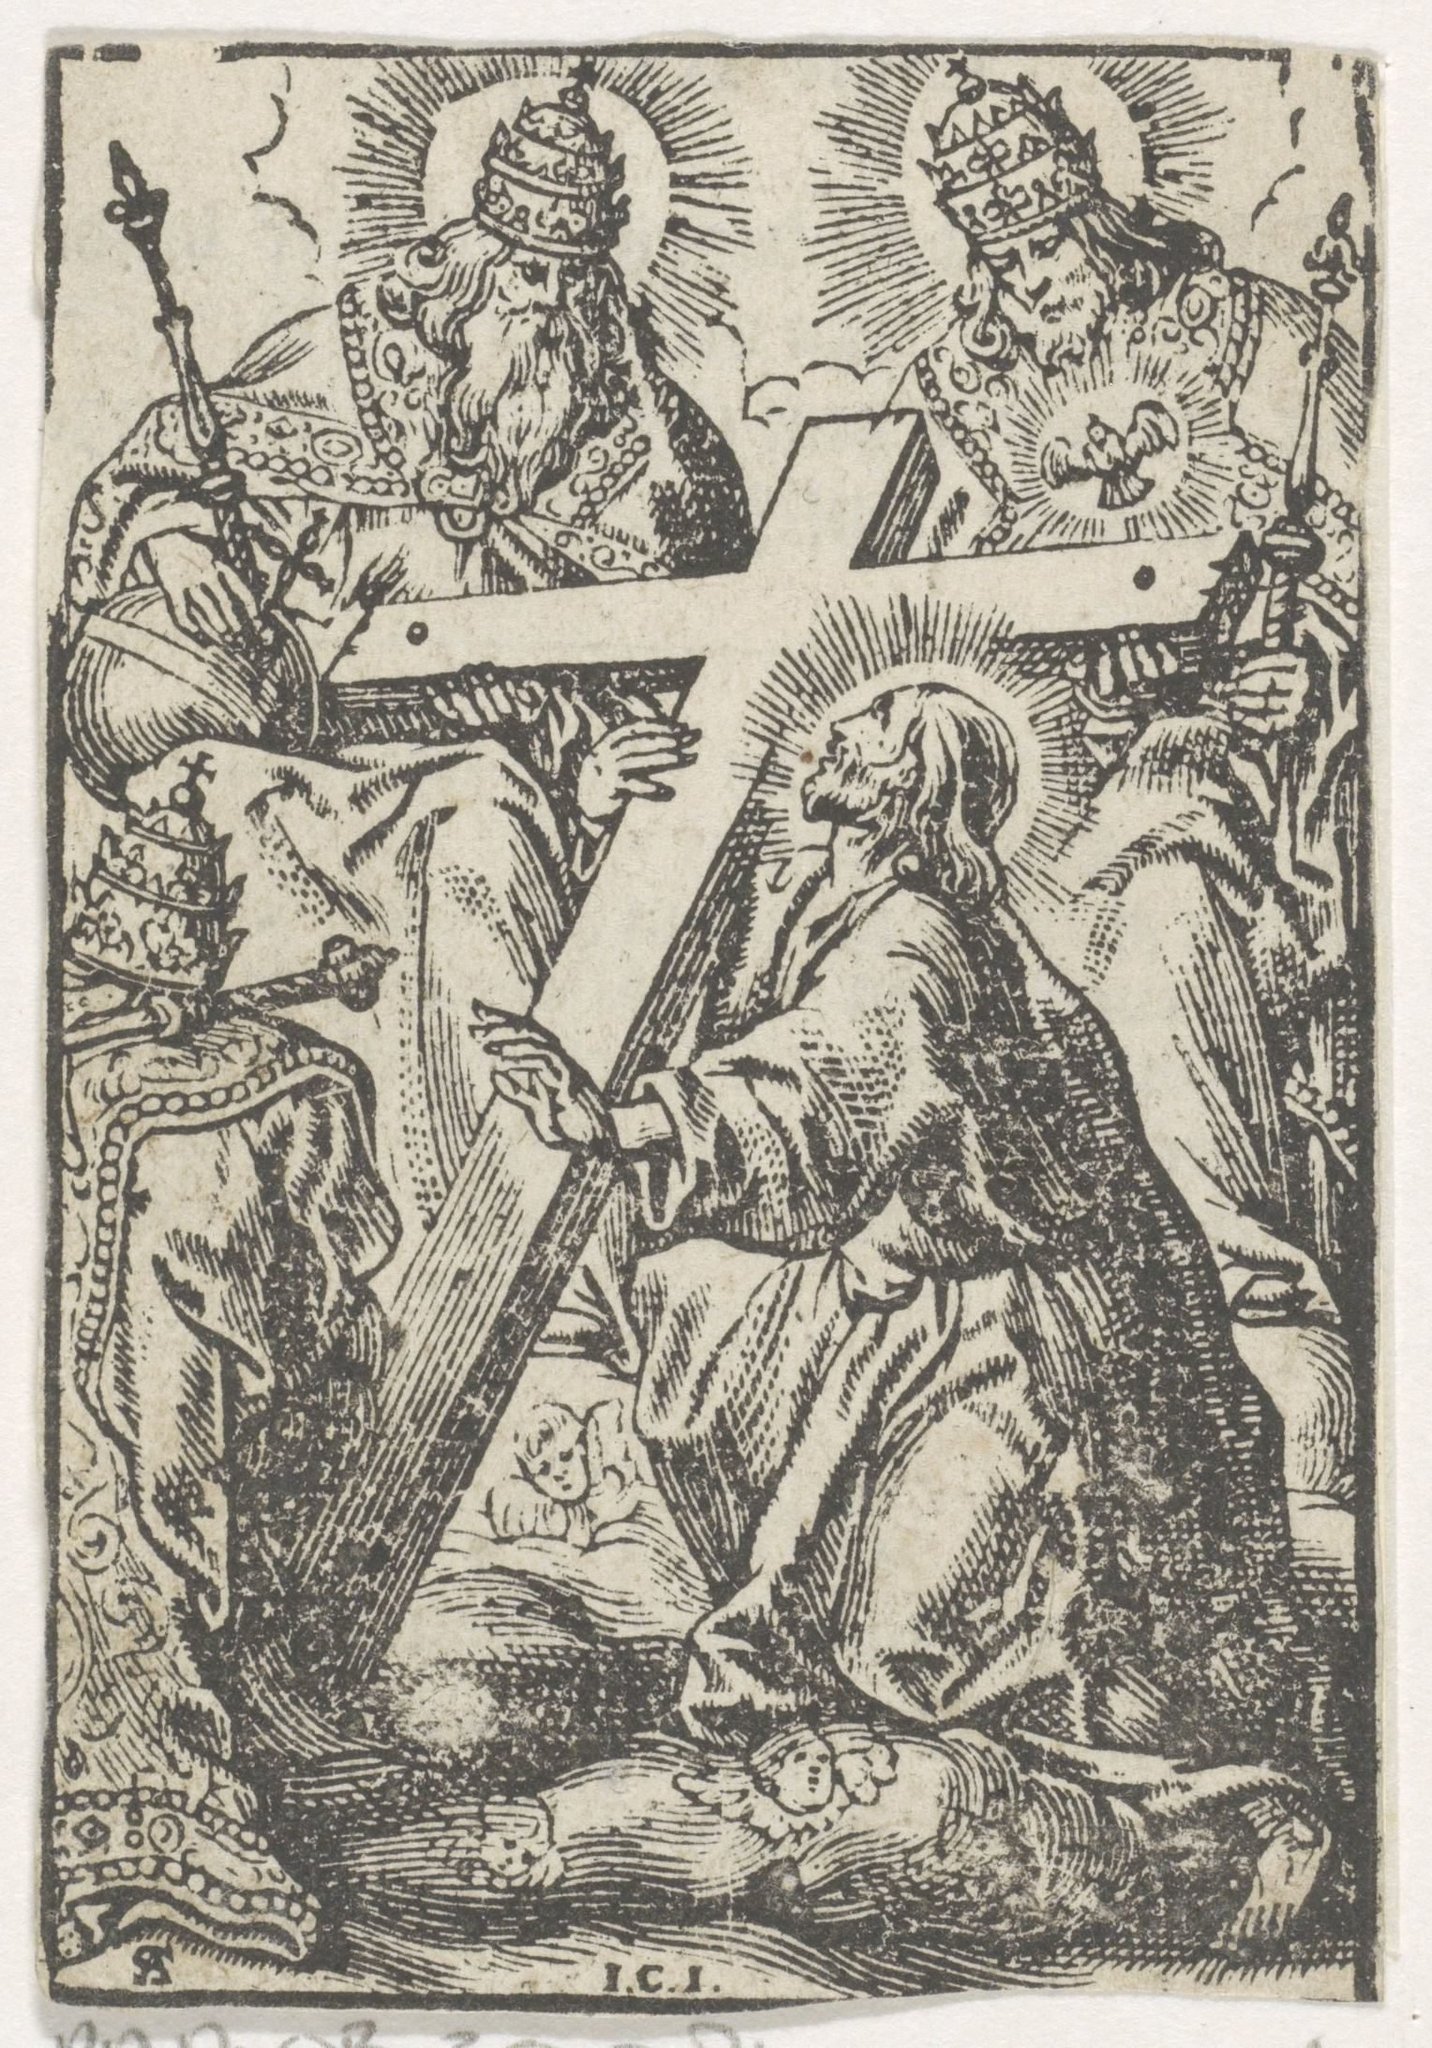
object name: book illustration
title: Heilige Drie-eenheid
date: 1649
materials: paper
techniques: letterpress printing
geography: antwerp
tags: trinity as three persons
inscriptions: collector's mark: Lugt 240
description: De Heilige Drie-eenheid zit op wolken tussen een aantal cherubijnen. Links zit God in de gedaante van een man met een wereldbol, een scepter en een kroon en rechts zit de Heilige Geest in de gedaante van een man met een duif, een scepter en een kroon. Op de voorgrond zit Christus geknield met het kruis. Hij ontvangt ook een scepter en een kroon.